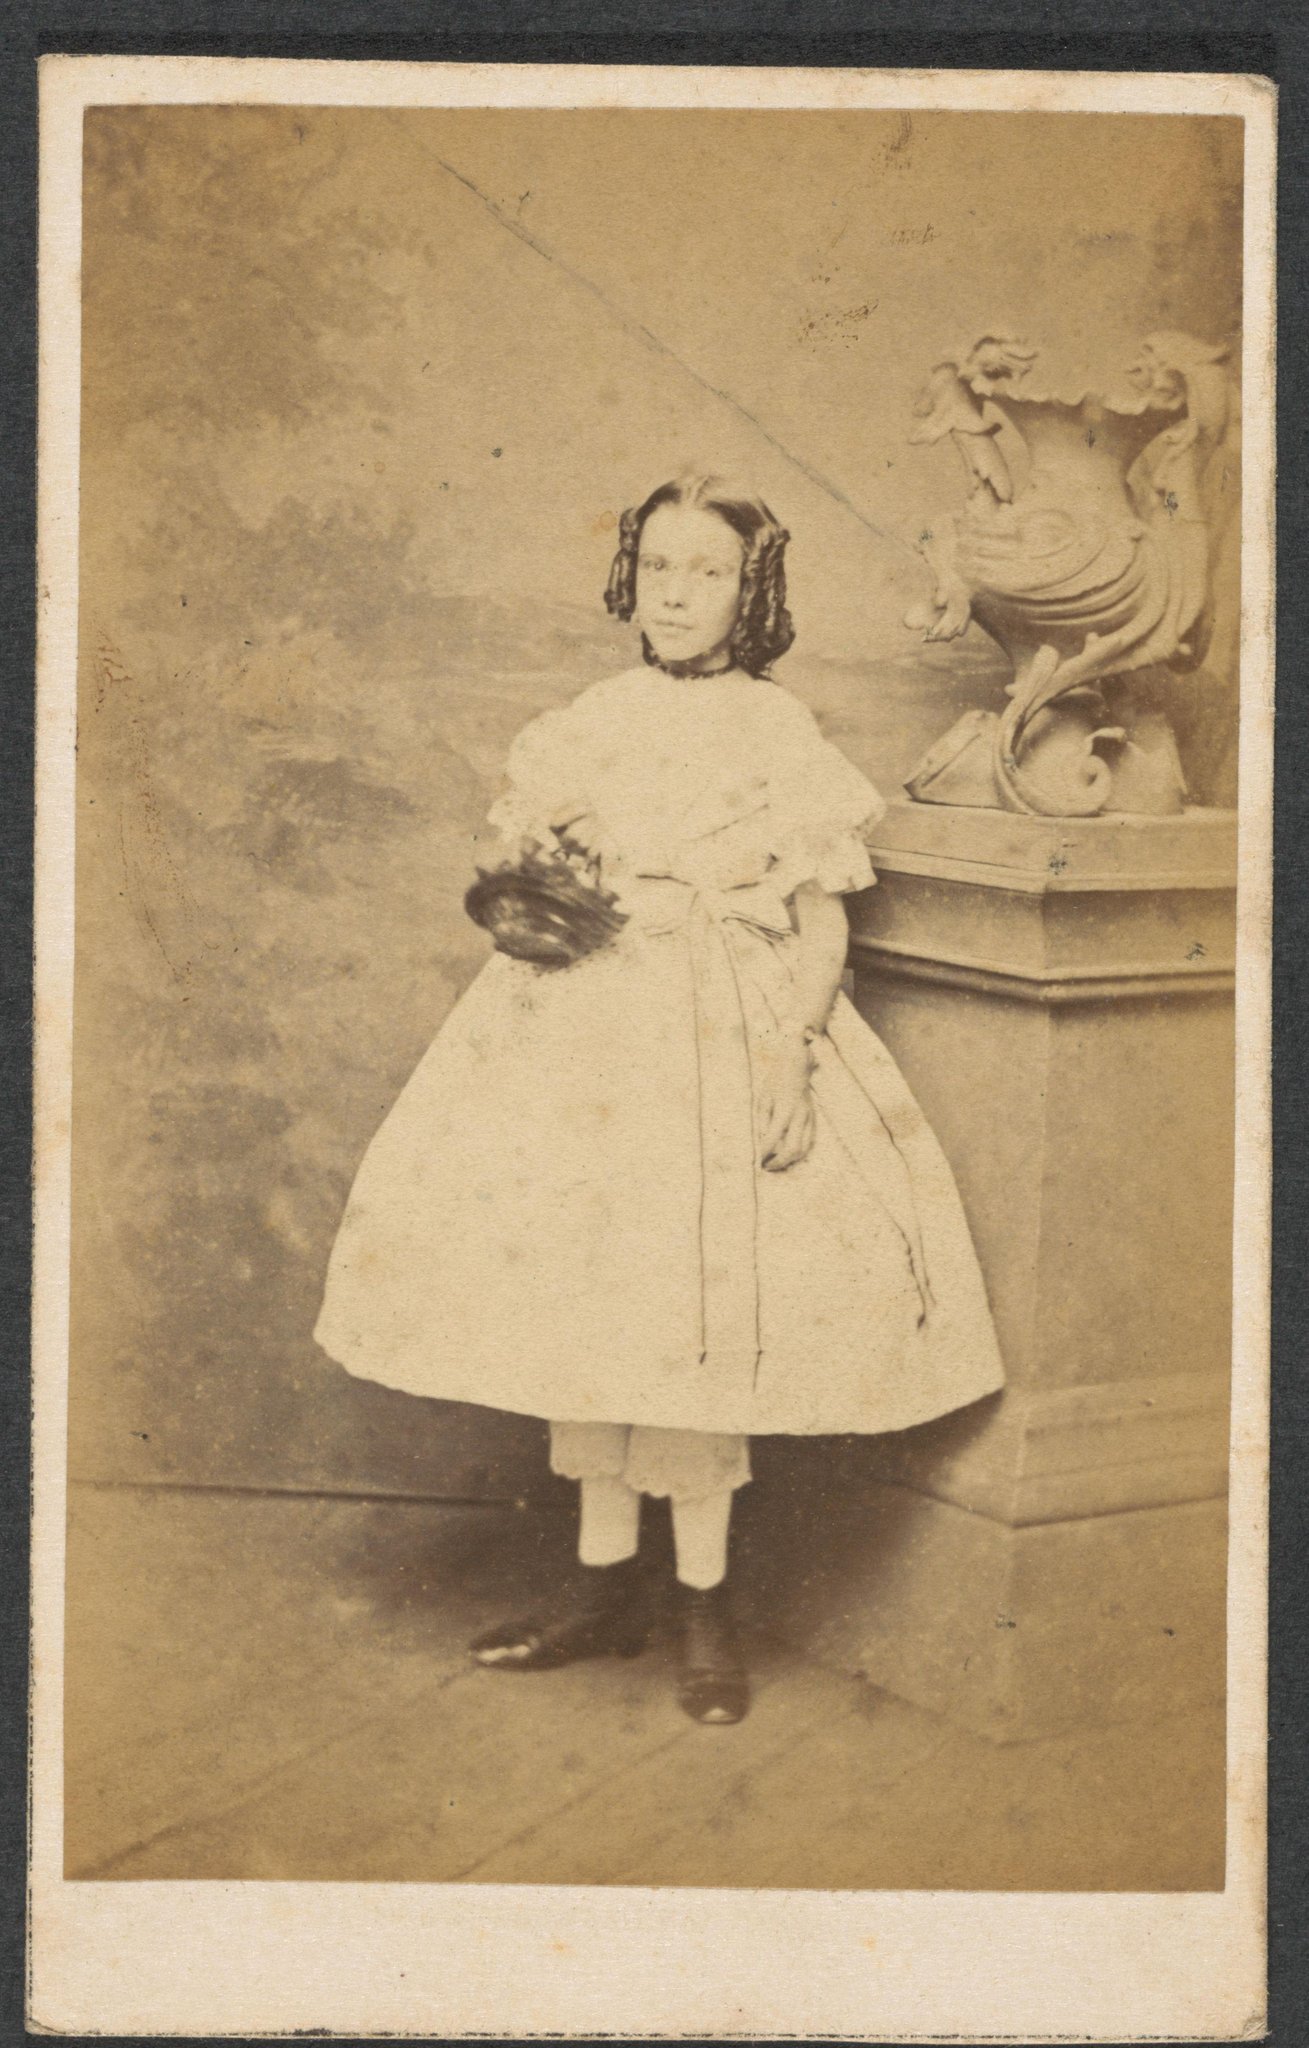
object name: carte de visite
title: Portret van een onbekend meisje uit de familie Marmelstein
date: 1865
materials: cardboard, photographic support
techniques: albumen print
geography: amsterdam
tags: historical persons not known by name - bb - woman, child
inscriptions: address: ‘ENGELSCH/ Photographisch Etablissement/ Kalverstraat bij de Munt/ D. 39.’